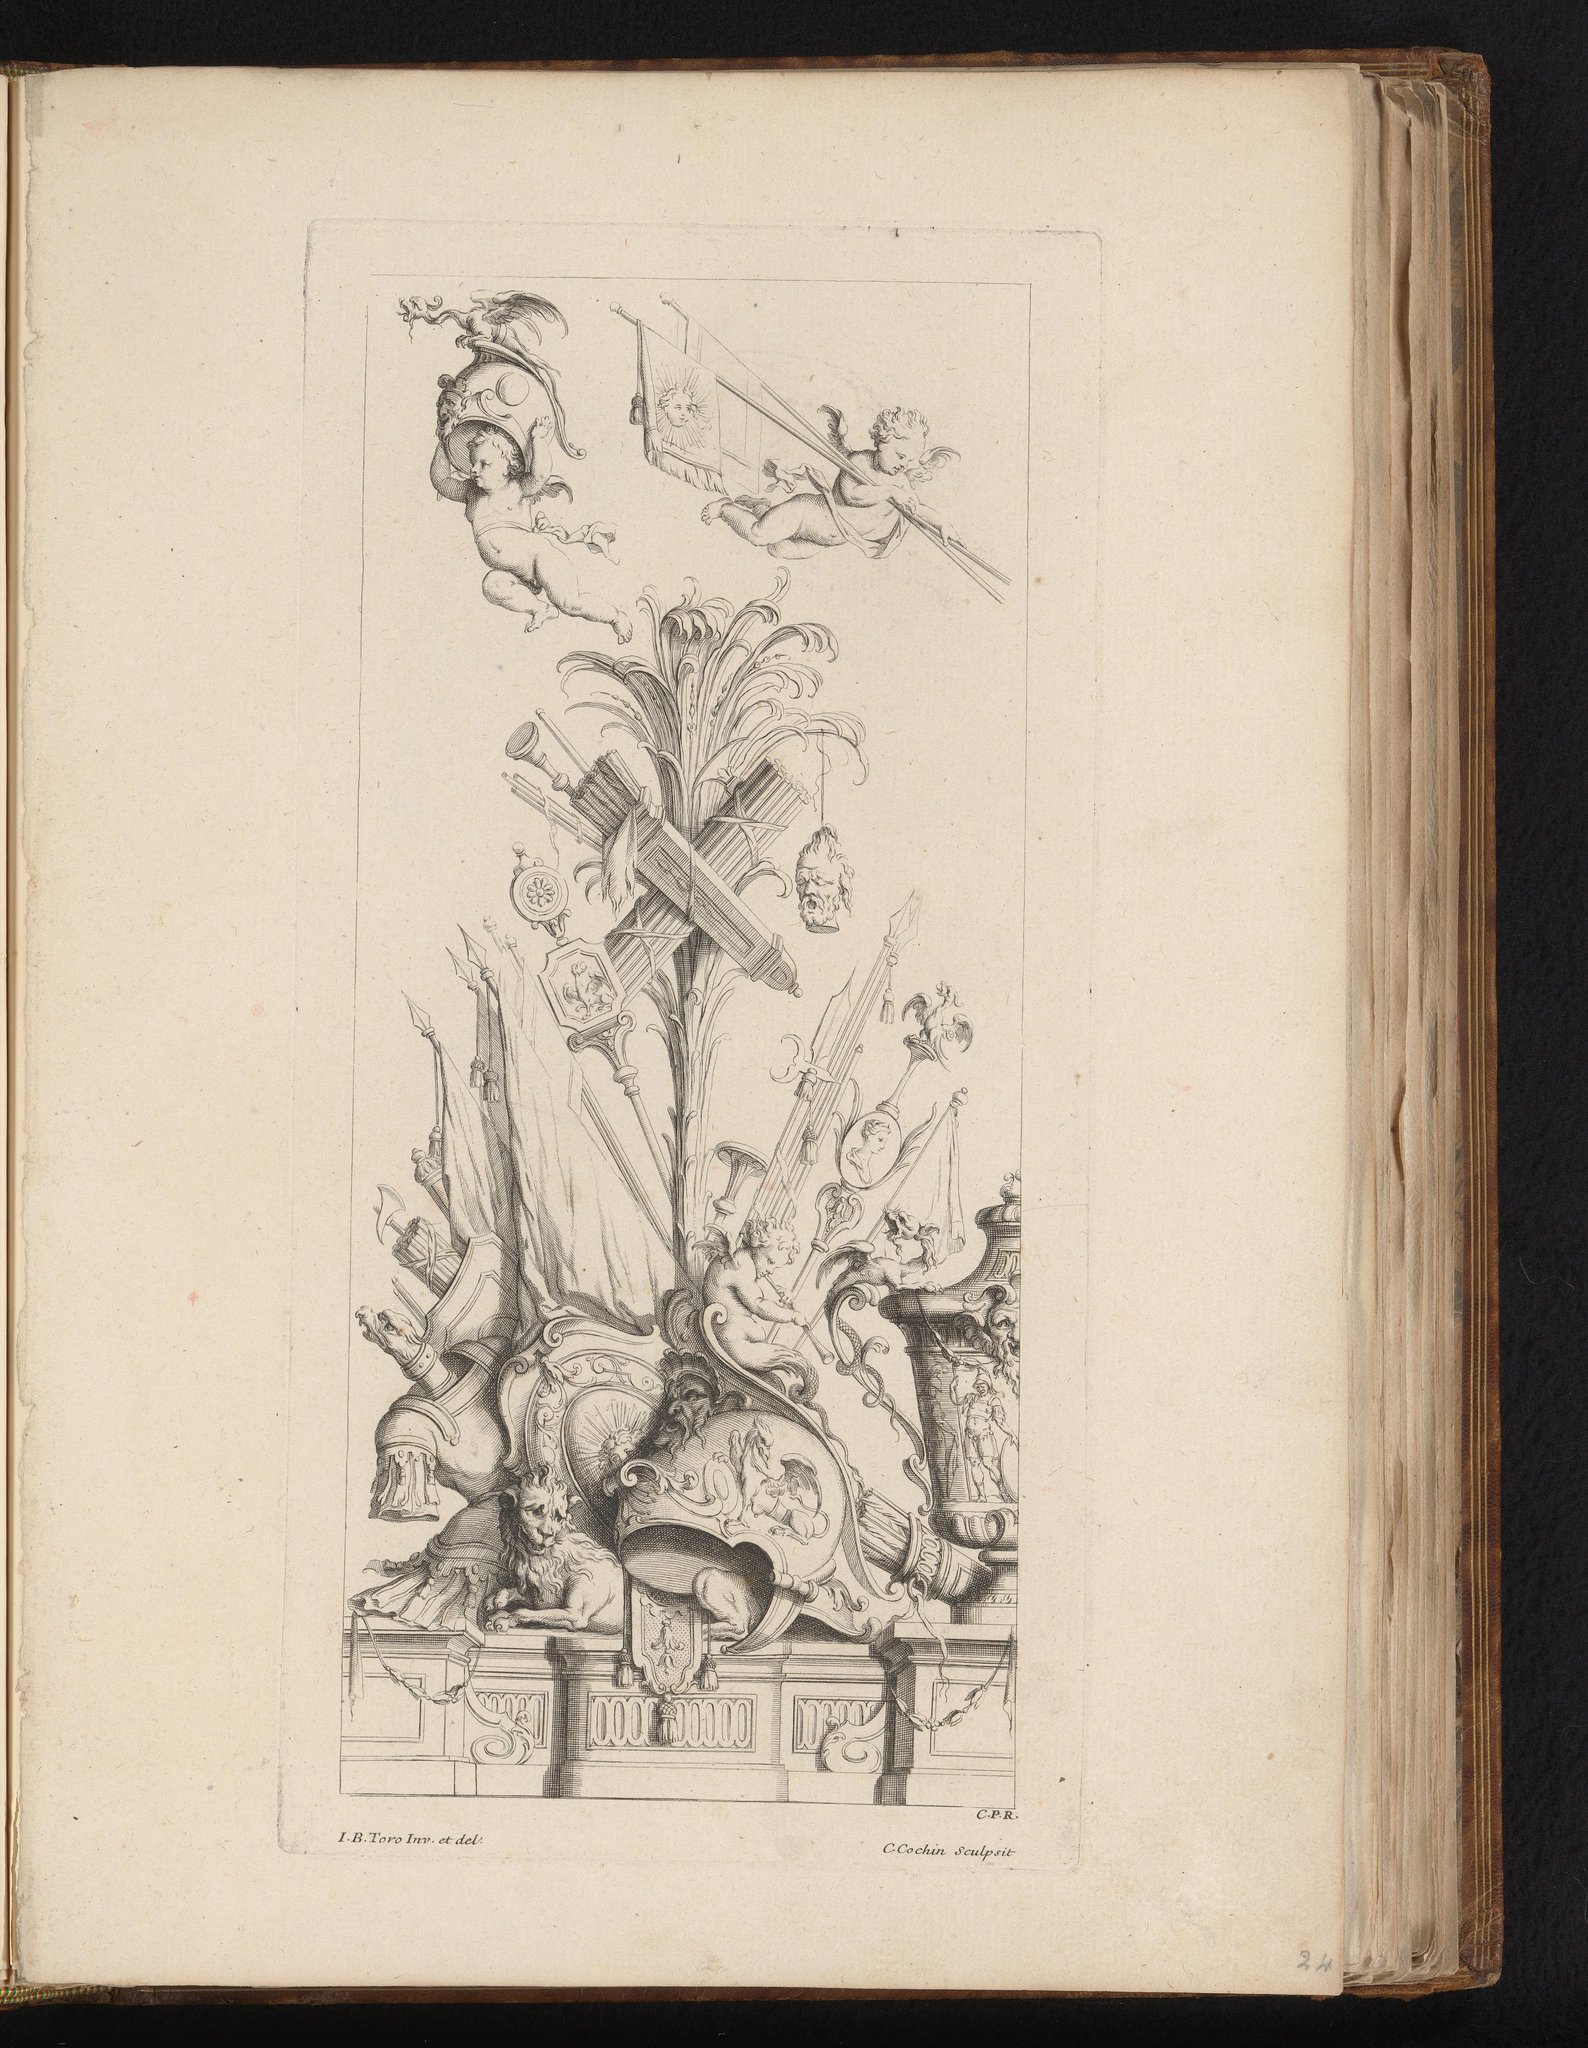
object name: ornament print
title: Trophées Nouvellement Inventés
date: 1716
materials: paper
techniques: engraving, etching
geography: france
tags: 'tropaion', i.e. decorative ornament ~ weapons, cupids: 'amores', 'amoretti', 'putti'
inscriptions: collector's mark: Lugt 2228, collector's mark: Lugt 2760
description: Prent maakt deel uit van een serie van zes prenten.